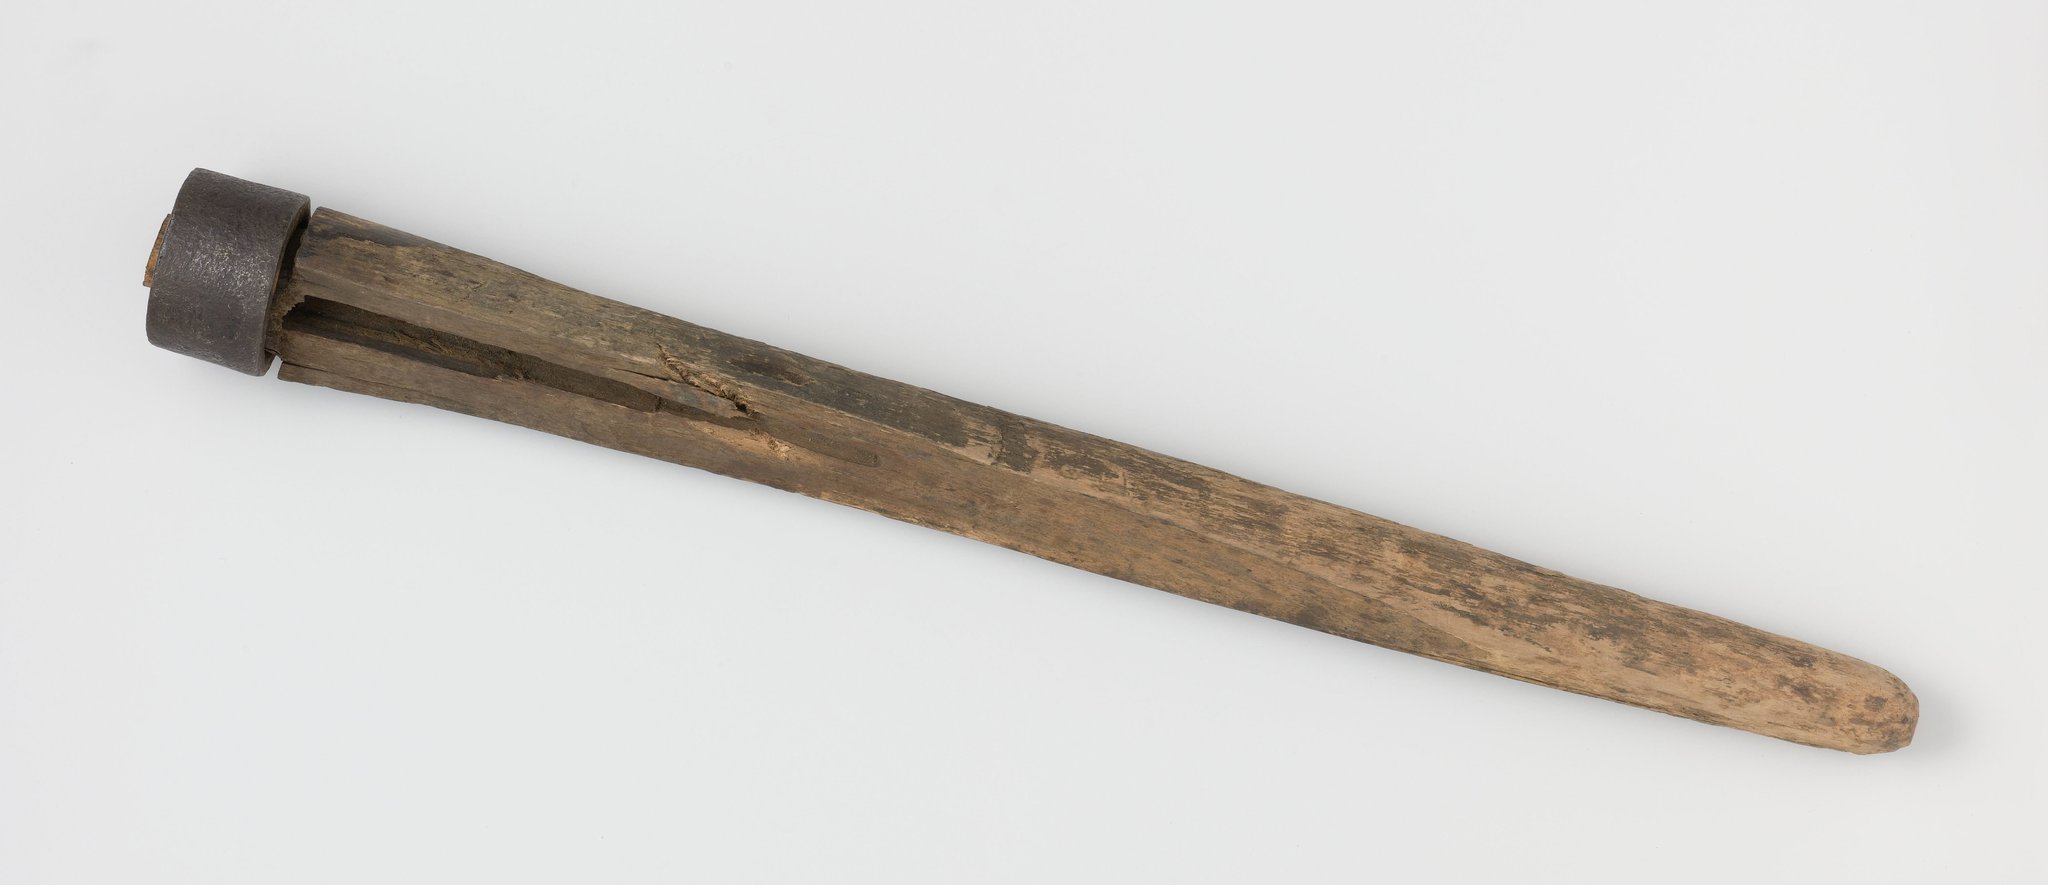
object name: handle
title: Handvat, spits toelopende stok van hout en ronde ijzeren ring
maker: Anonymous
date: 1590-1596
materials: iron, wood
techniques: cutting, forging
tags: willem barendsz., amsterdam, jacob van heemskerck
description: Handvat, onderdeel van werktuig bestaande uit een houten stok waarvan het ene uiteinde eindigd in een ronde ijzeren ring (los) en het andere uiteinde spits toeloopt Waarschijnlijk heeft in de ring oorspronkelijk een ijzeren angel gezeten. In de ring zit nu een klein stukje hout (is dit oorspronkelijk??).